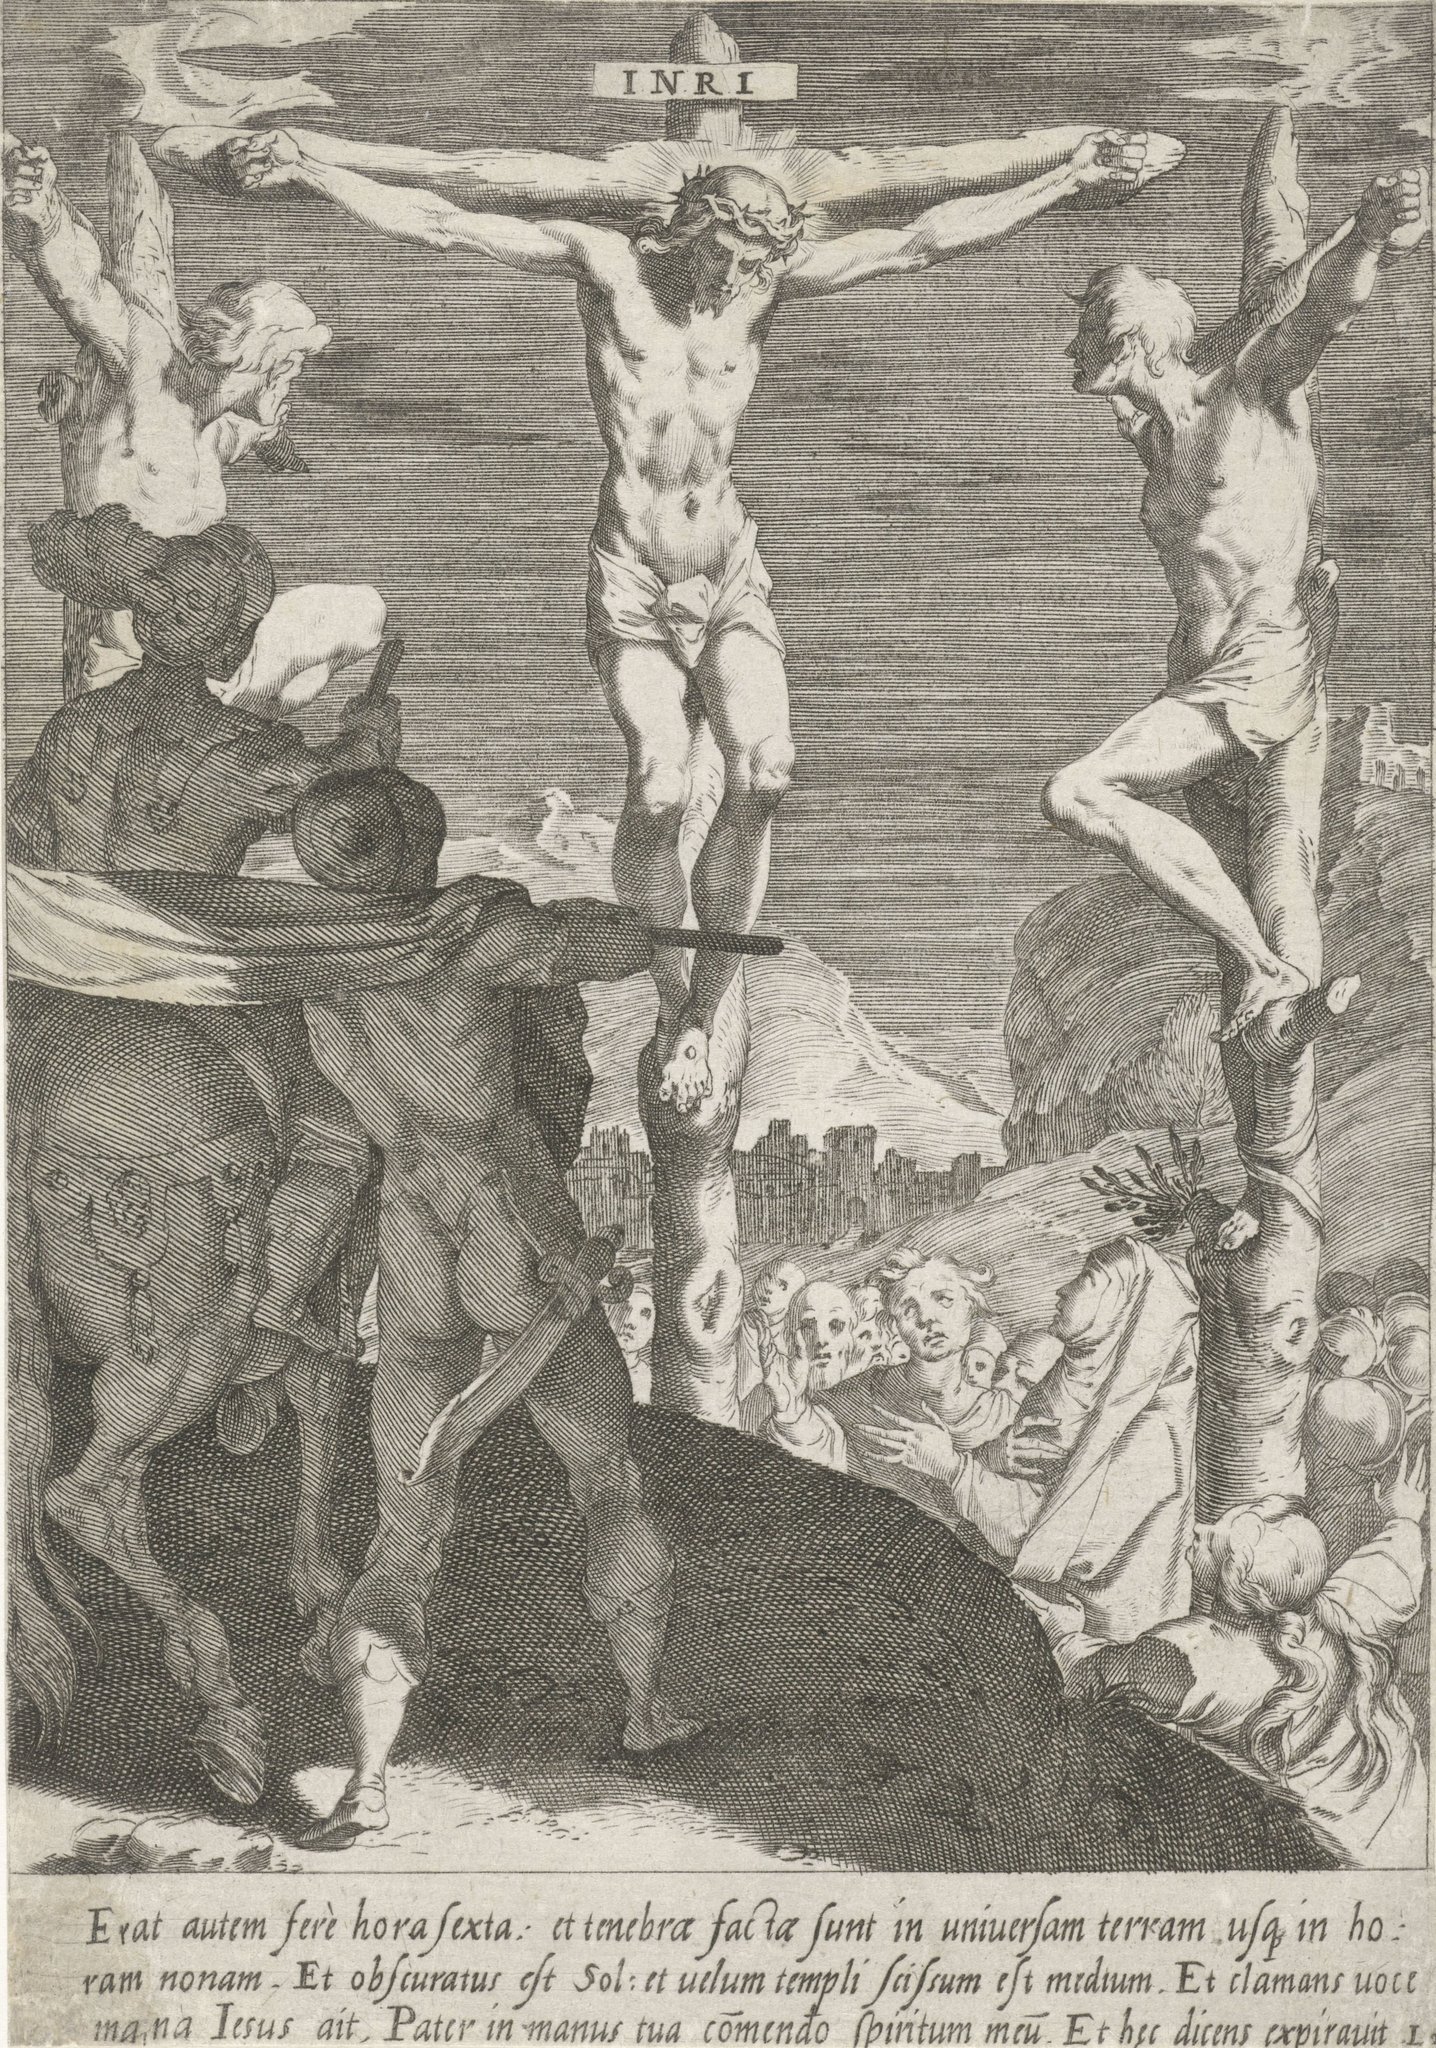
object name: print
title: Passionis et resurrectionis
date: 1590-1632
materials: paper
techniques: engraving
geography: italy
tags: the crucifixion of christ: christ's death on the cross; golgotha (matthew 27:45-58; mark 15:33-45; luke 23:44-52; john 19:25-38)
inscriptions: collector's mark: Lugt 2228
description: De kruisdood van Christus op de berg Golgota. Links en rechts van hem de misdadigers die samen met hem gekruisigd zijn. Onder het kruis bevinden zich Maria Magdalena, Maria, de Heilige Johannes en wenende toeschouwers. Op de voorgrond een ruiter en een soldaat met vlag. In de marge een drieregelig onderschrift in het Latijn. Prent uit een serie van vijftien met de passie van Christus.